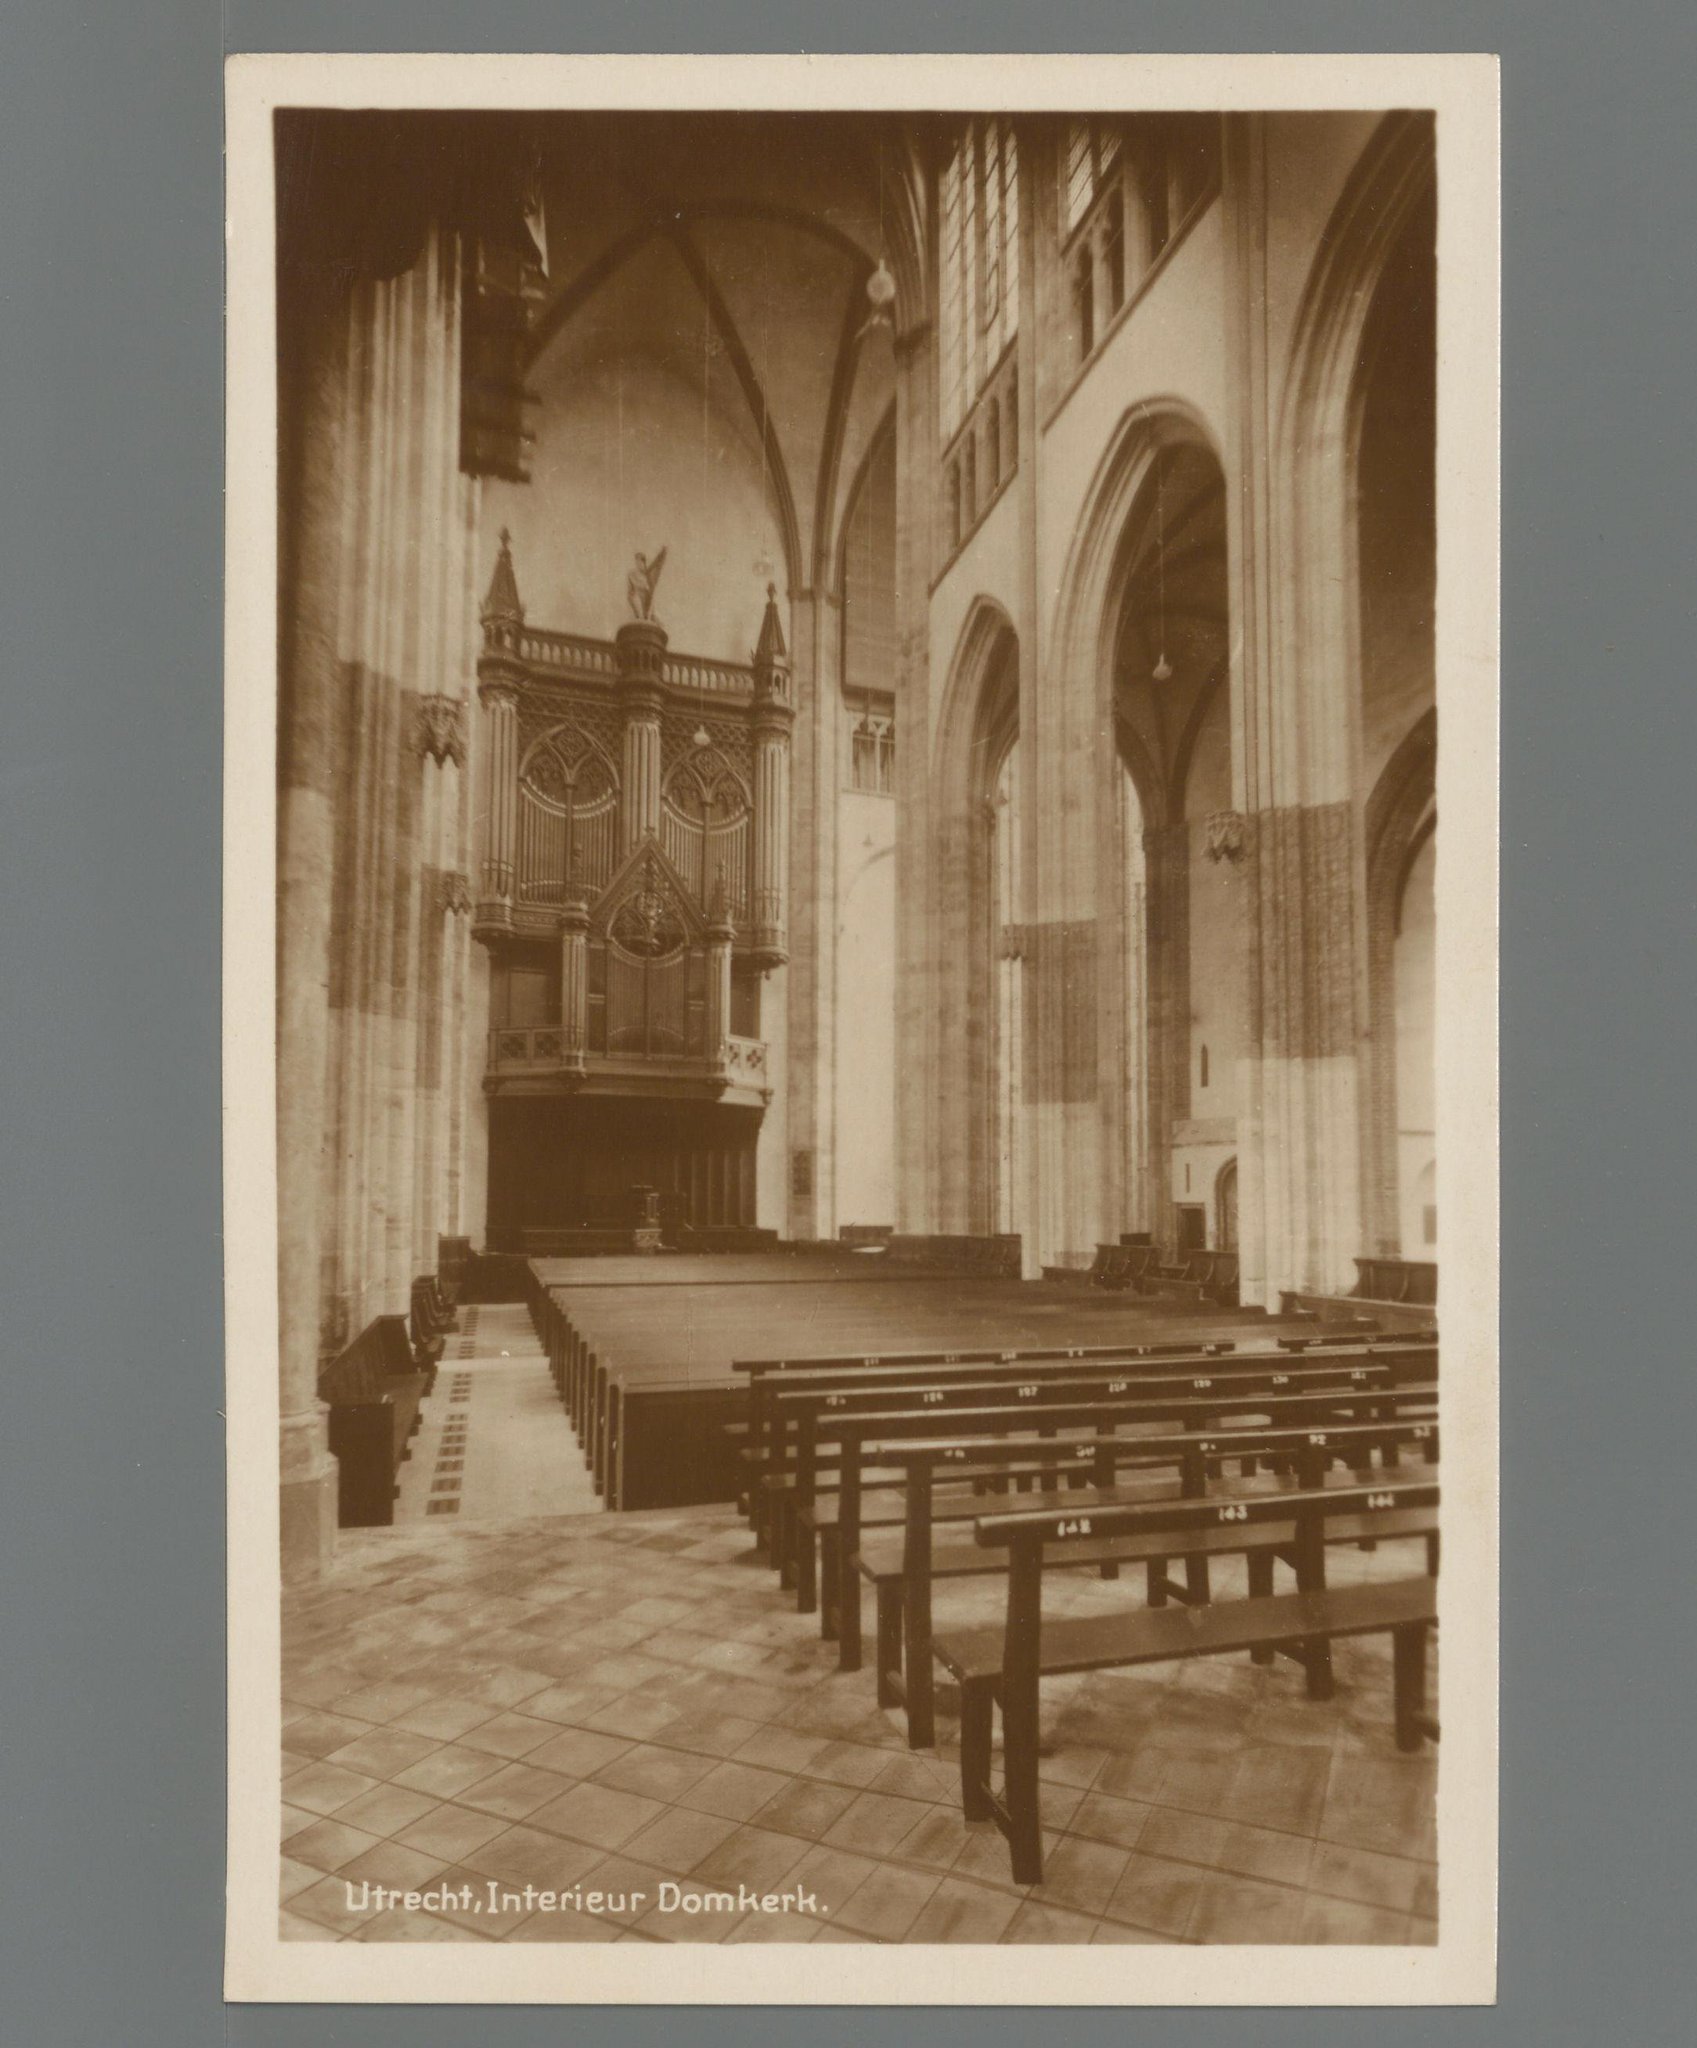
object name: photograph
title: Utrecht. Interieur Domkerk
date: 1925-1950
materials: photographic support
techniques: photography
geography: utrecht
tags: interior of church